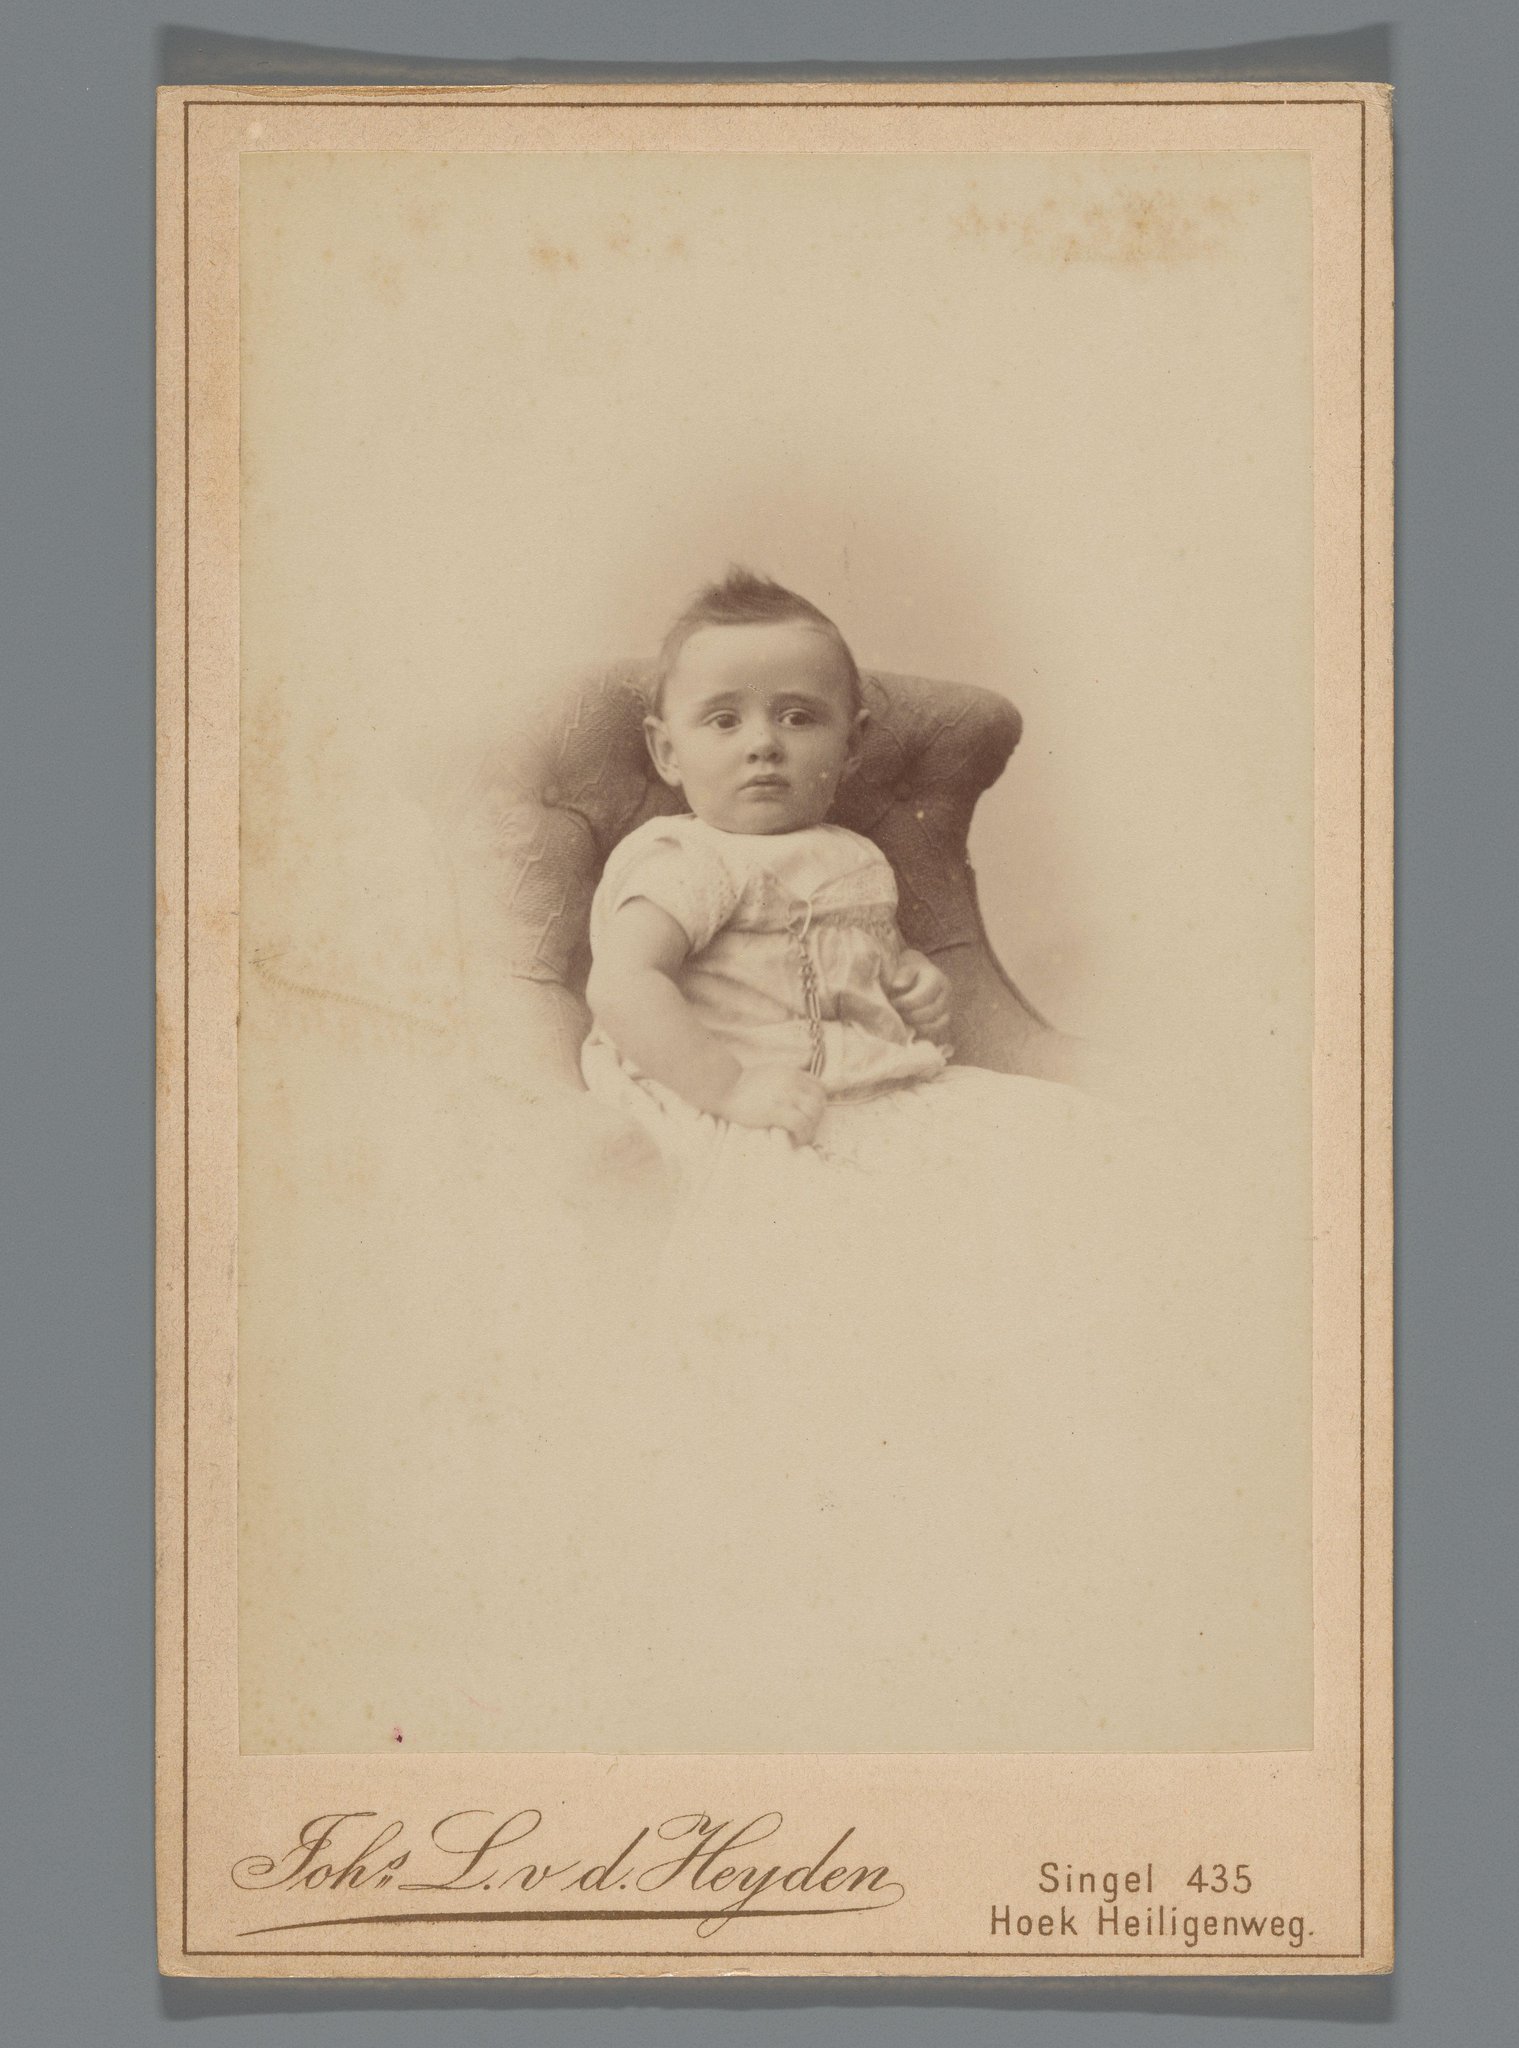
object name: cabinet photograph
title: Portret van een onbekend kind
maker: johannes leonardus van der heijden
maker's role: fotograaf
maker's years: 1856-1937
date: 1890-1906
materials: cardboard, paper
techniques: albumen print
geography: amsterdam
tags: anonymous historical person portrayed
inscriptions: address: ‘Singel 435/ Hoek Heiligenweg.’